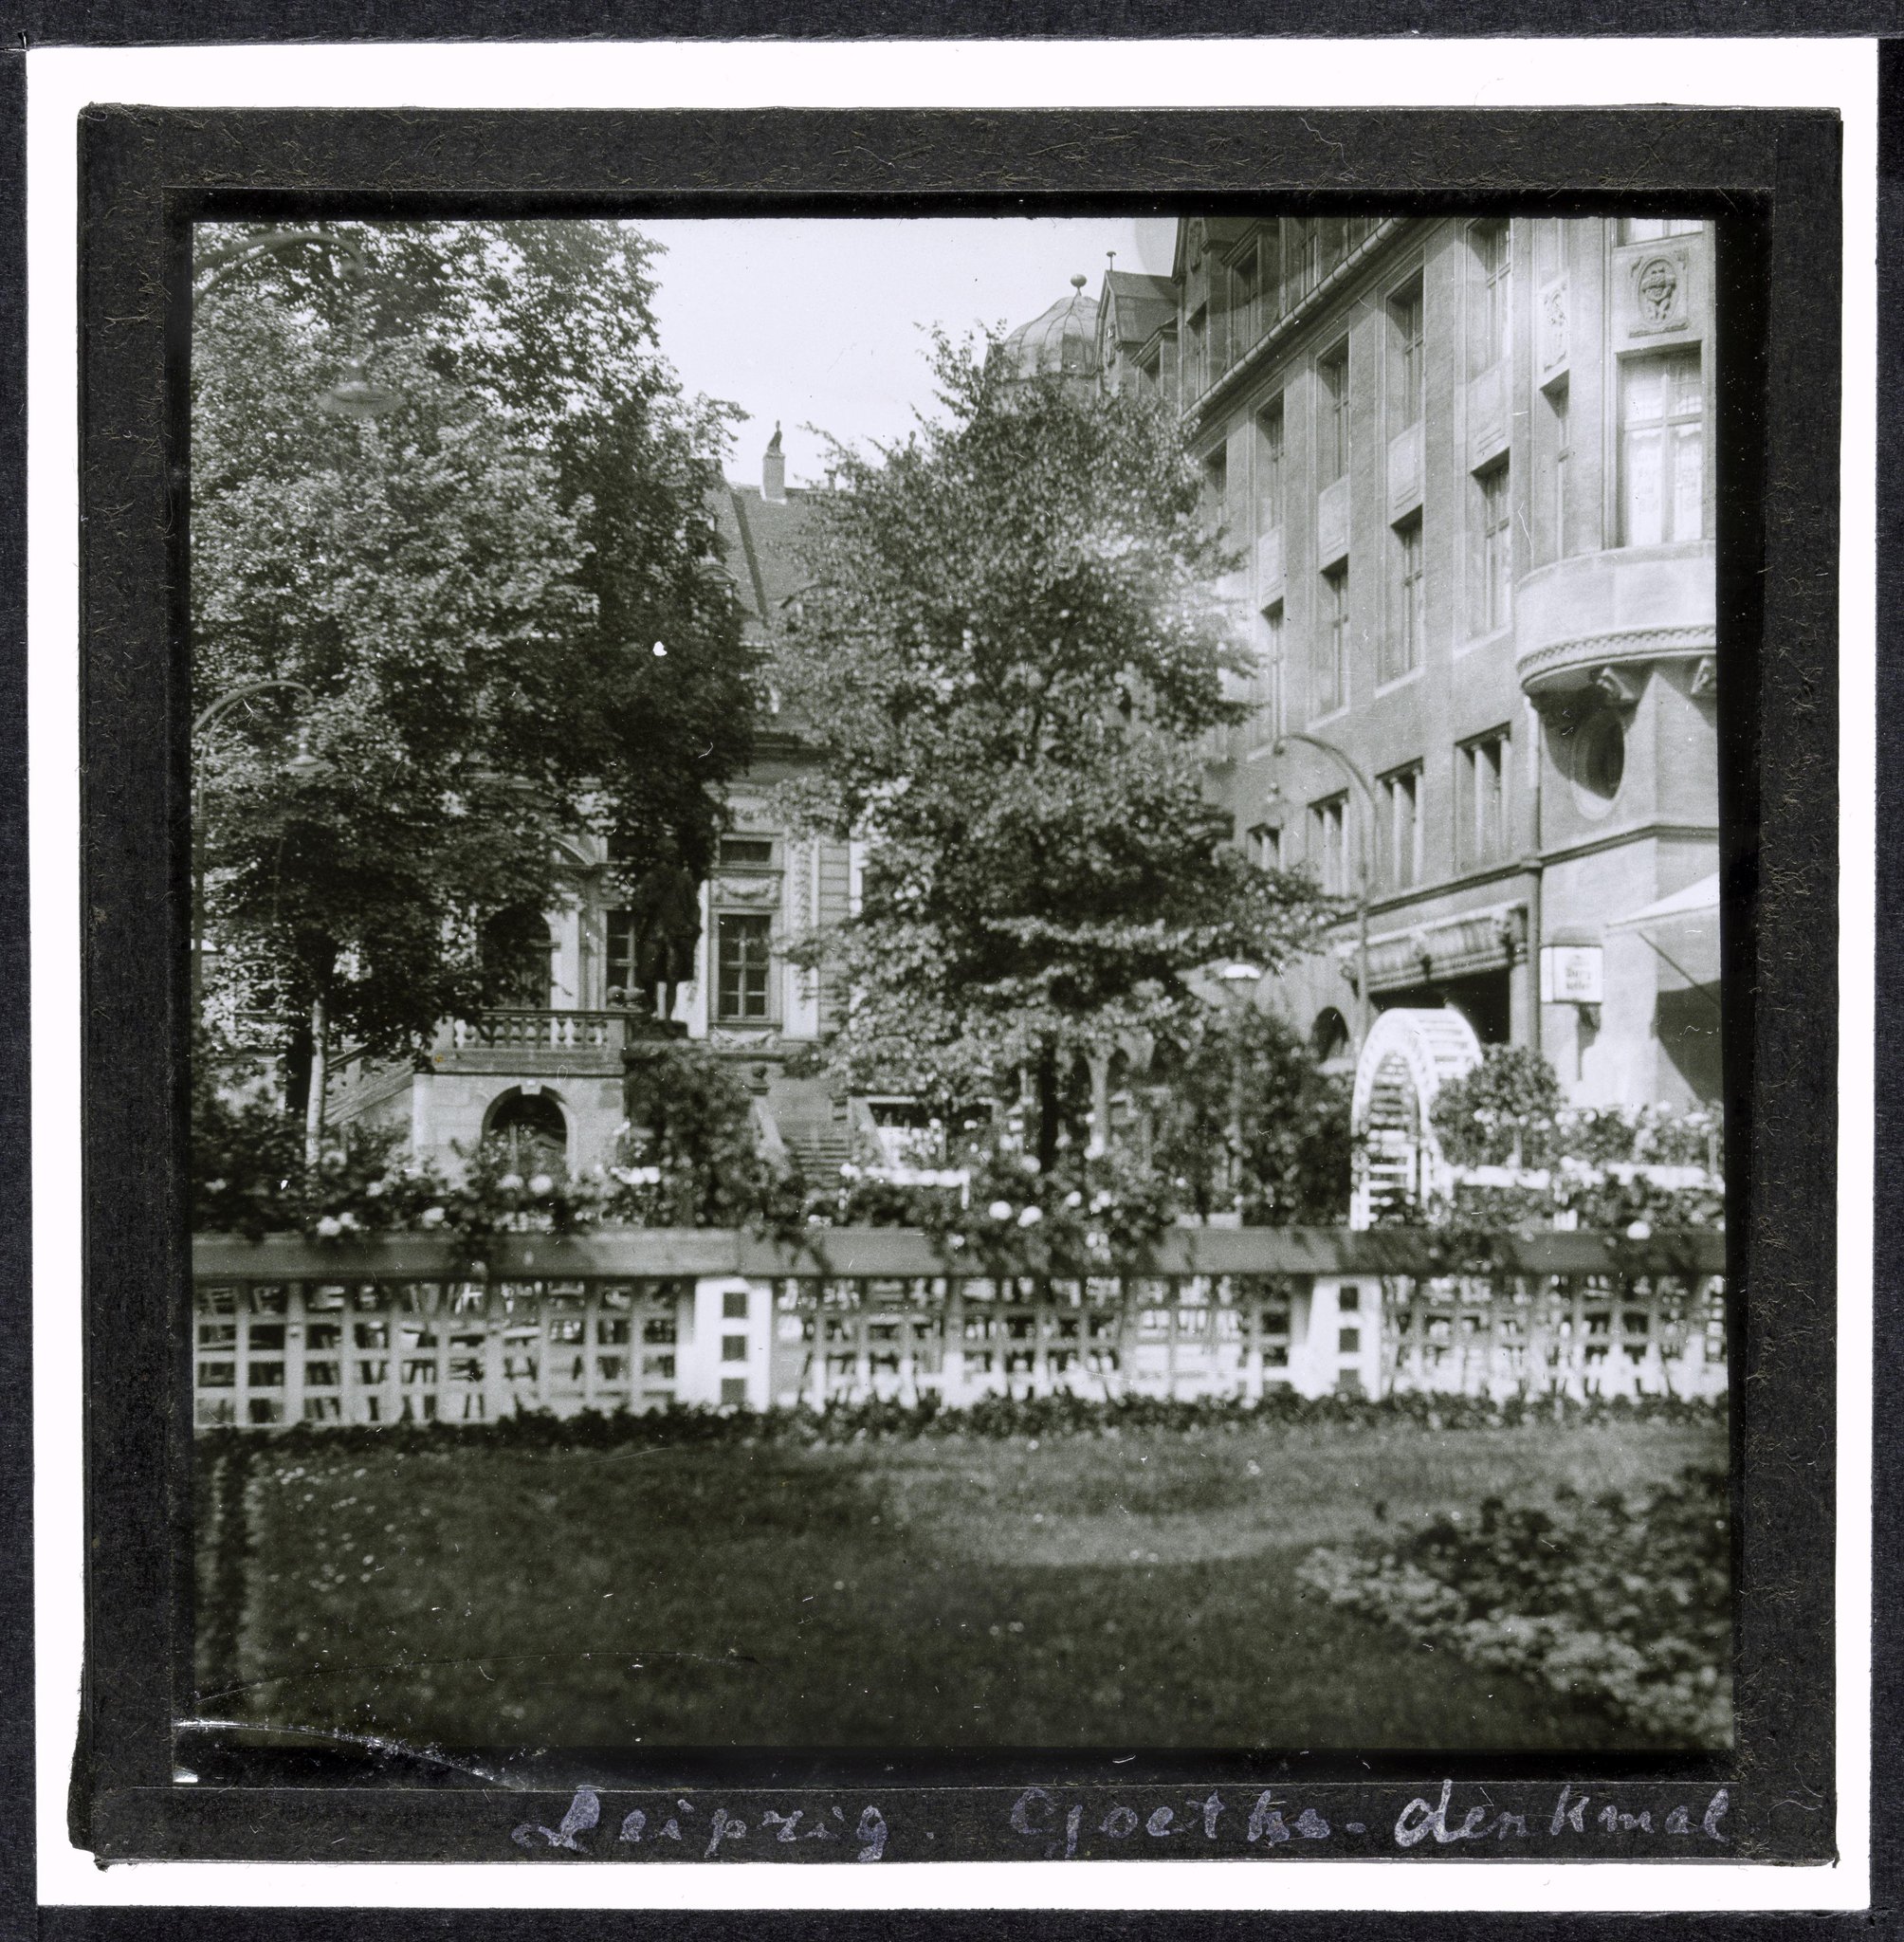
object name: glasdia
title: Leipzig. Goethe-denkmal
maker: Anonymous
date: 1907-1935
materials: glass, ink, paper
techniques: slide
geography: leipzig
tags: square, place, circus, etc.